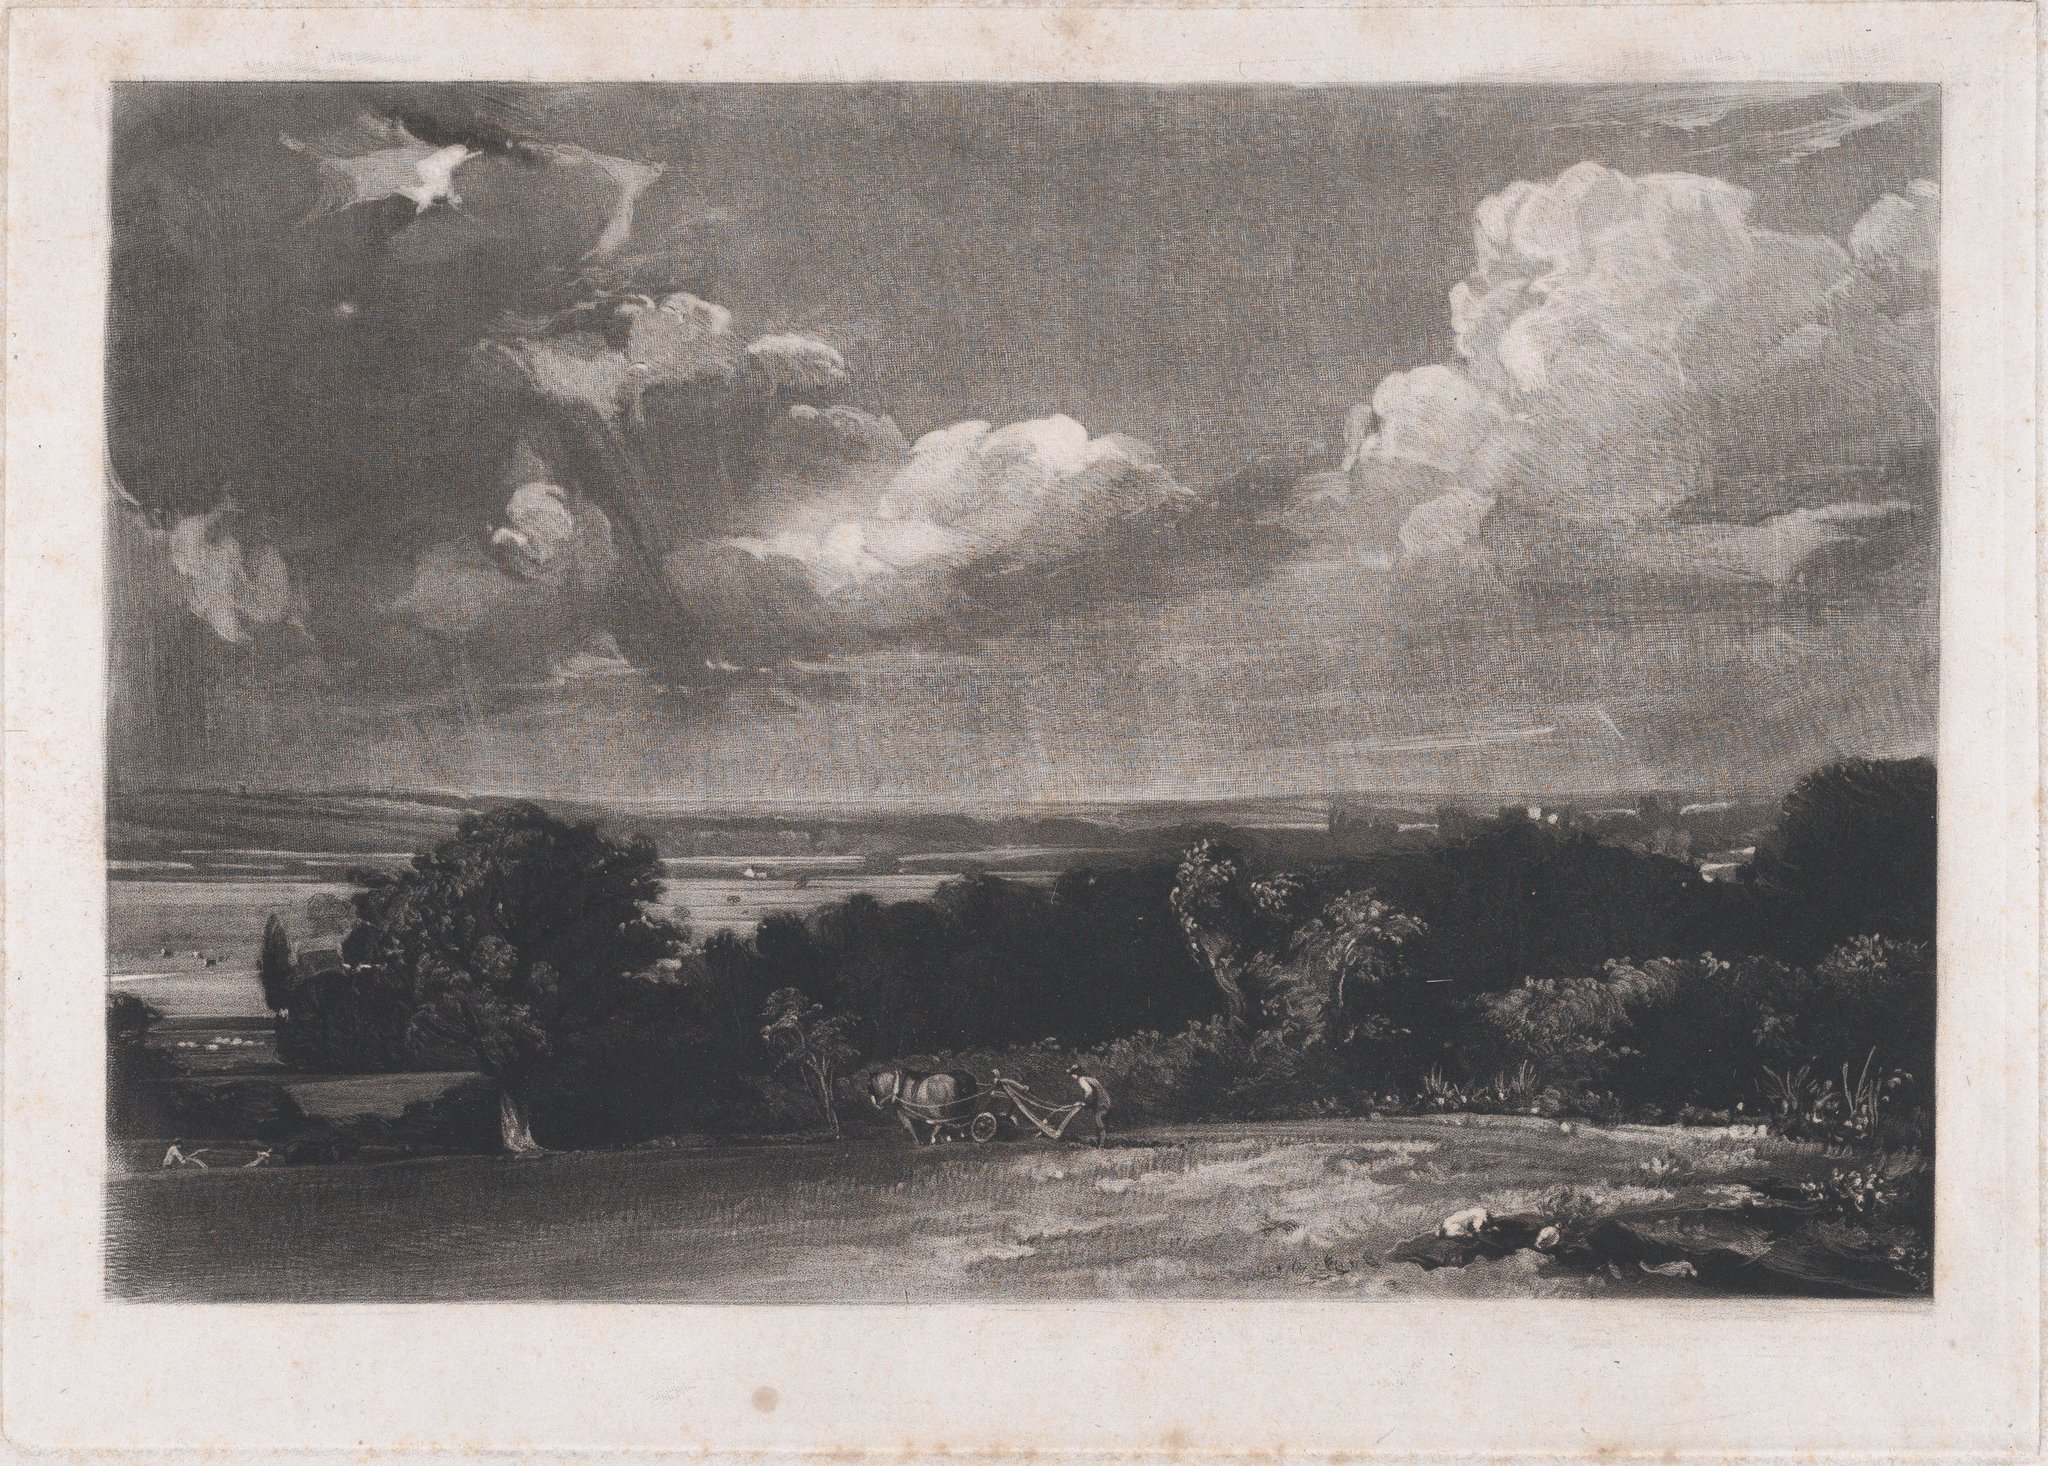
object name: print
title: A Summerland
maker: david lucas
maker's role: artist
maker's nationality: british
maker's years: 1802-1881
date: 1829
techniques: mezzotint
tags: animals,men,landscapes,farmers